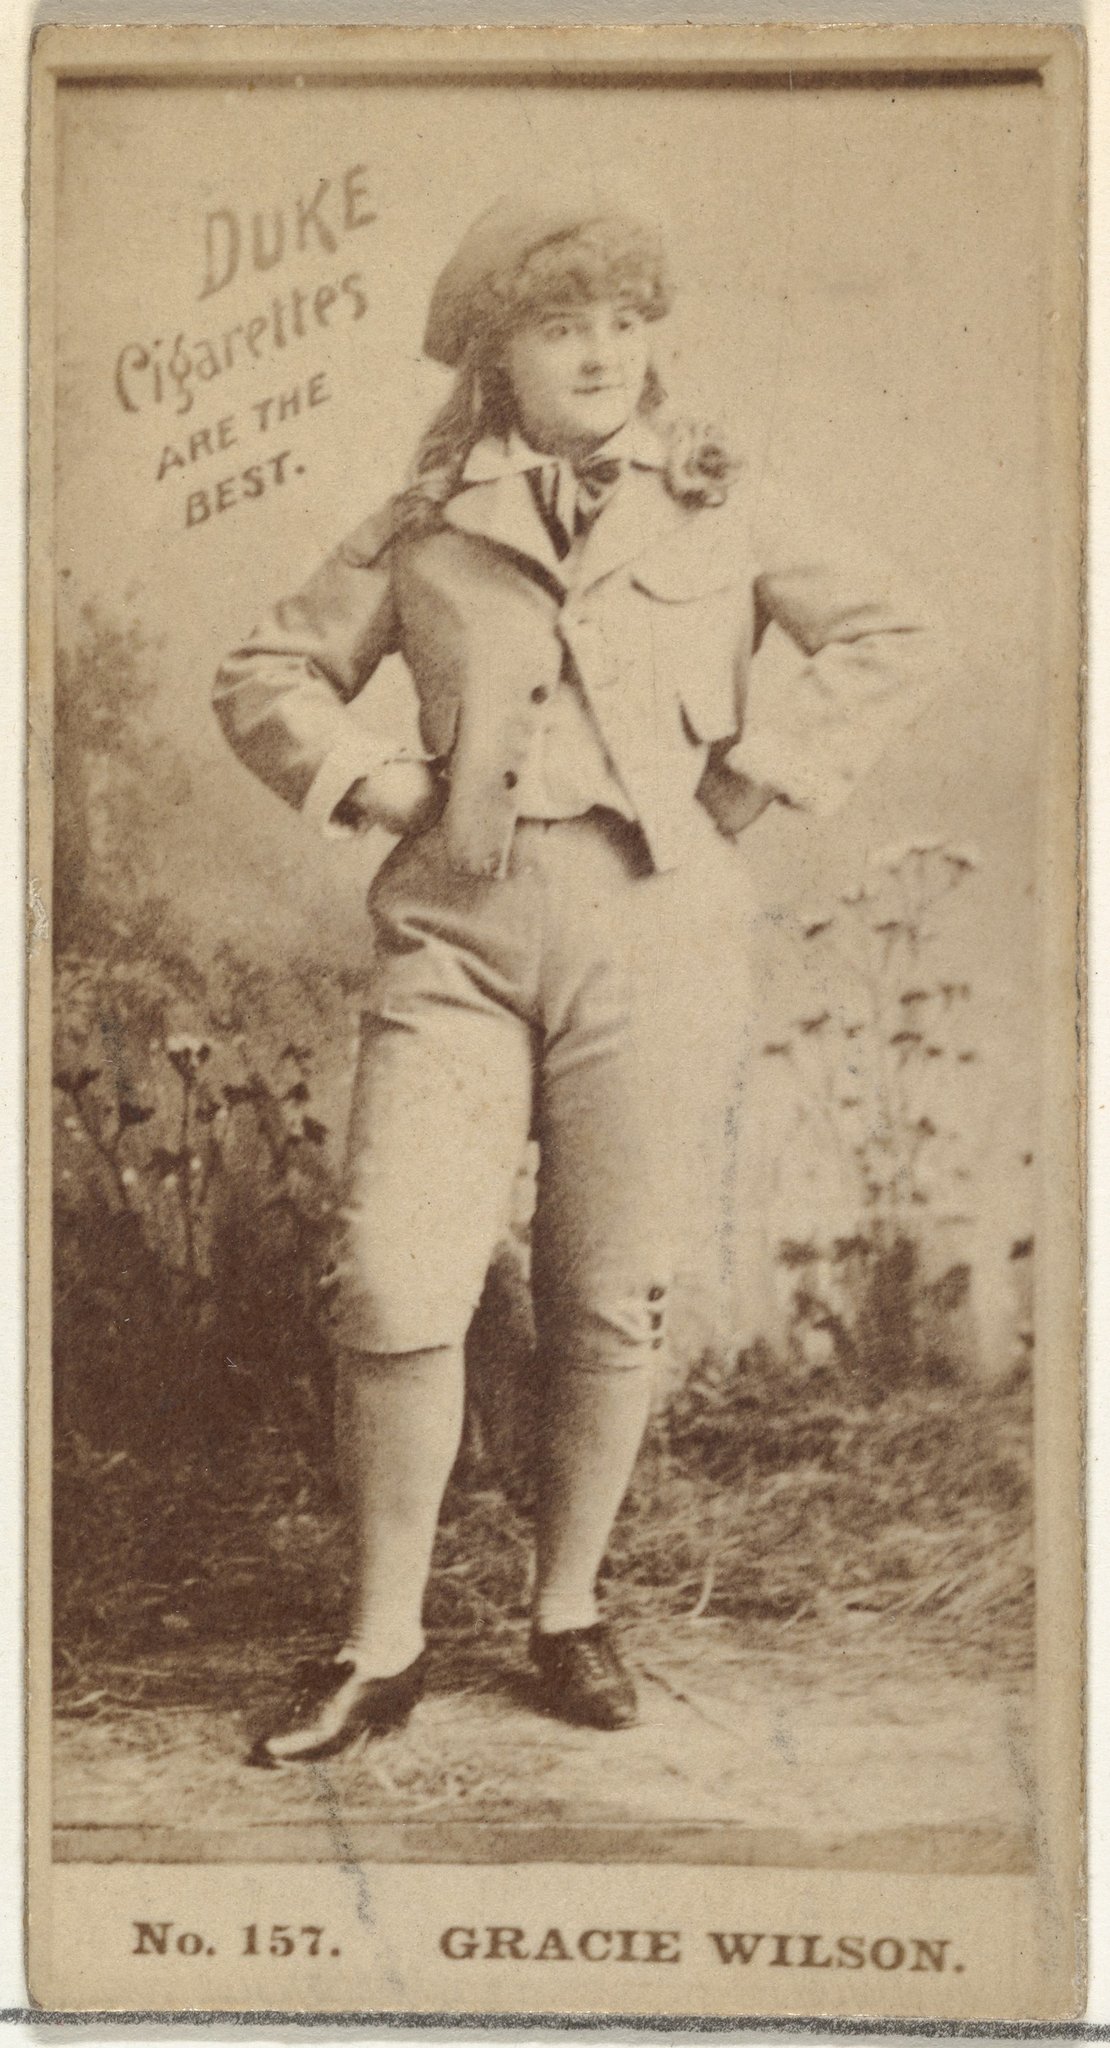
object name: photograph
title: Card Number 157, Gracie Wilson, from the Actors and Actresses series (N145-6) issued by Duke Sons & Co. to promote Duke Cigarettes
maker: w. duke, sons & co.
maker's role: publisher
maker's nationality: american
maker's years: 1870-1920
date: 1880-1889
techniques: albumen silver print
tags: portraits,women,actresses